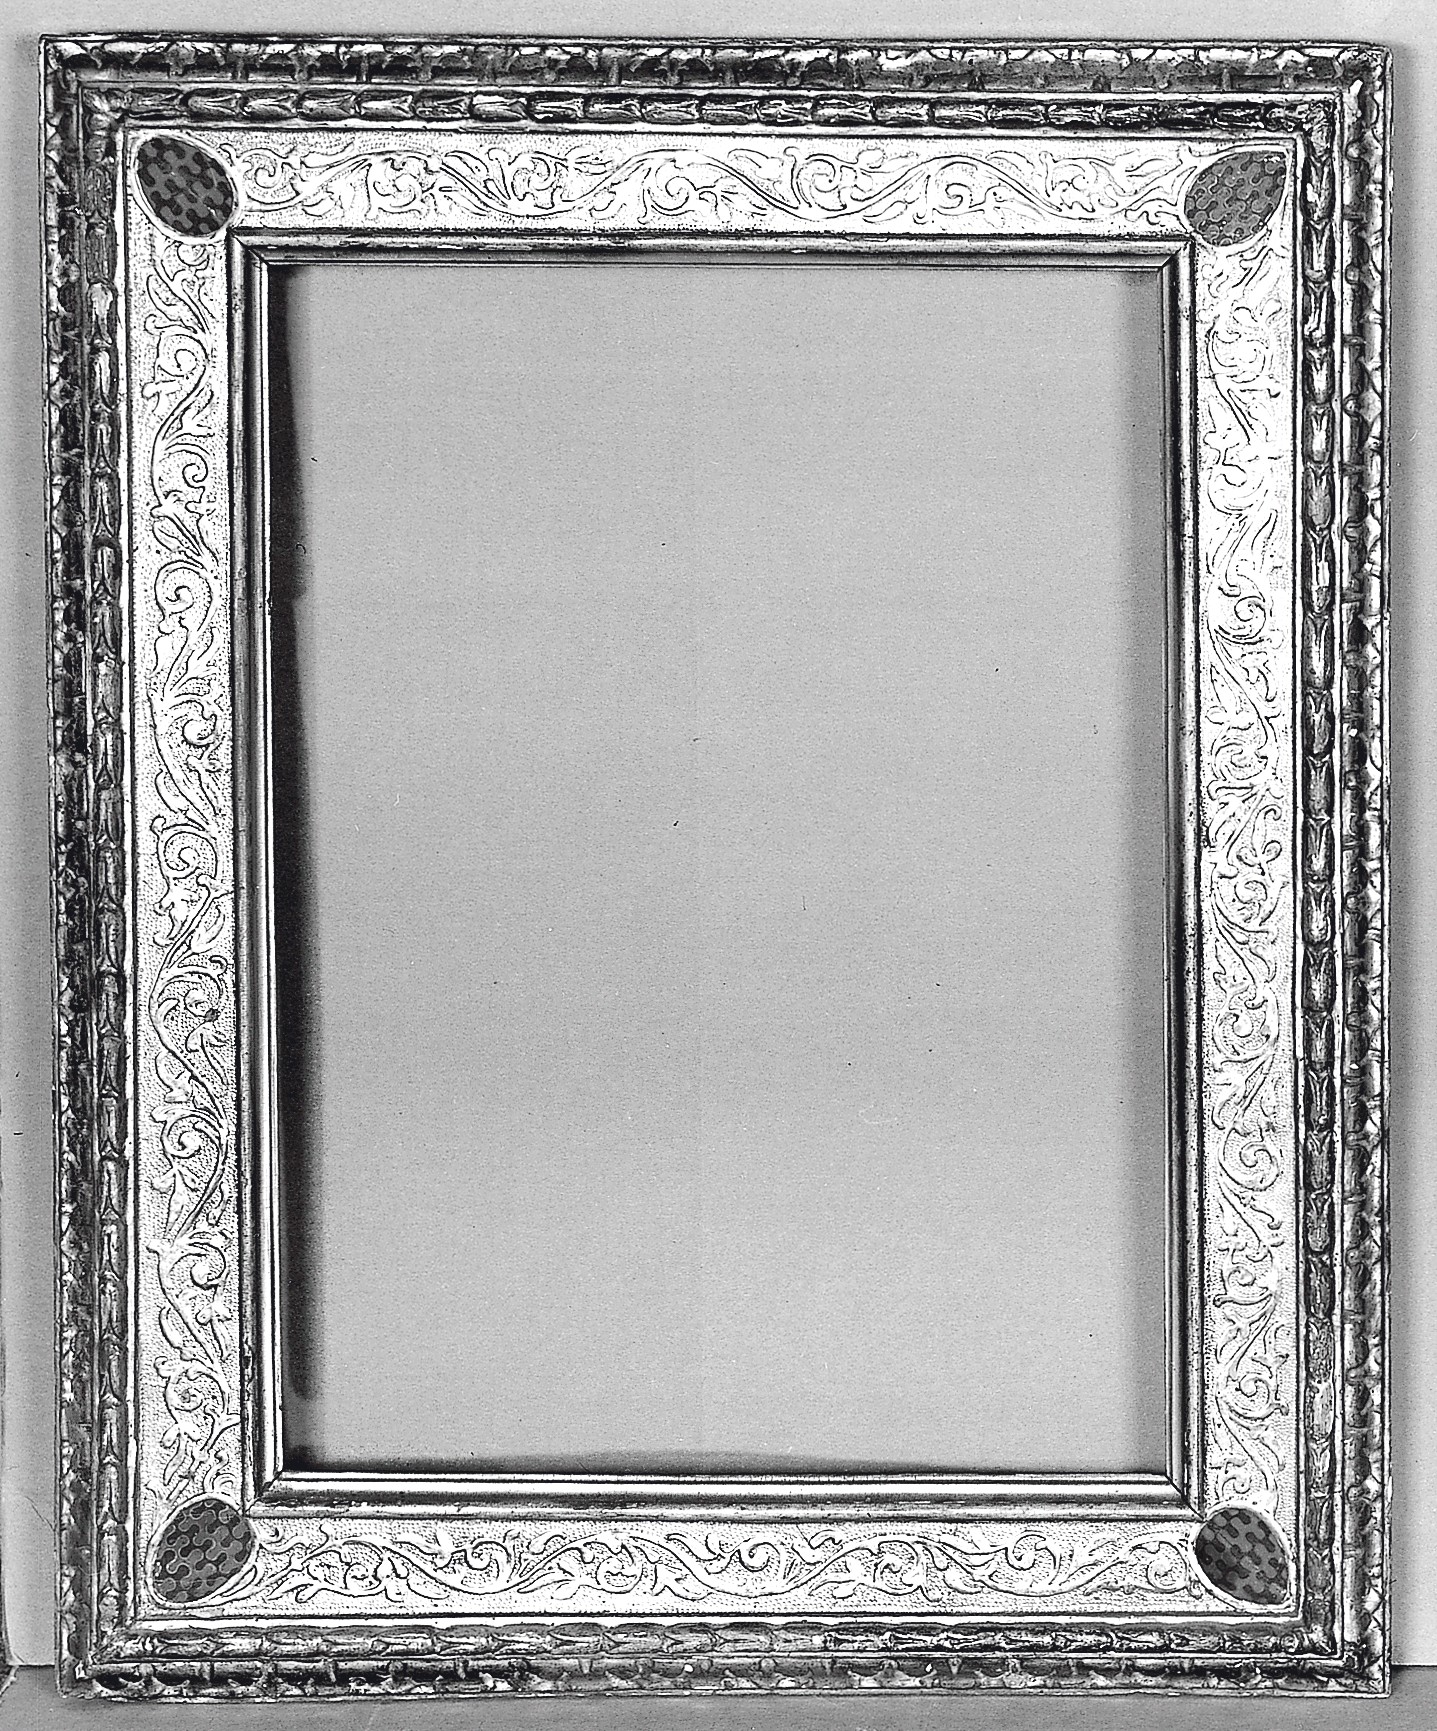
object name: frame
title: Cassetta frame (pair with 1975.1.96b)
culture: italian, lombardy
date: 1601-1633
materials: wood